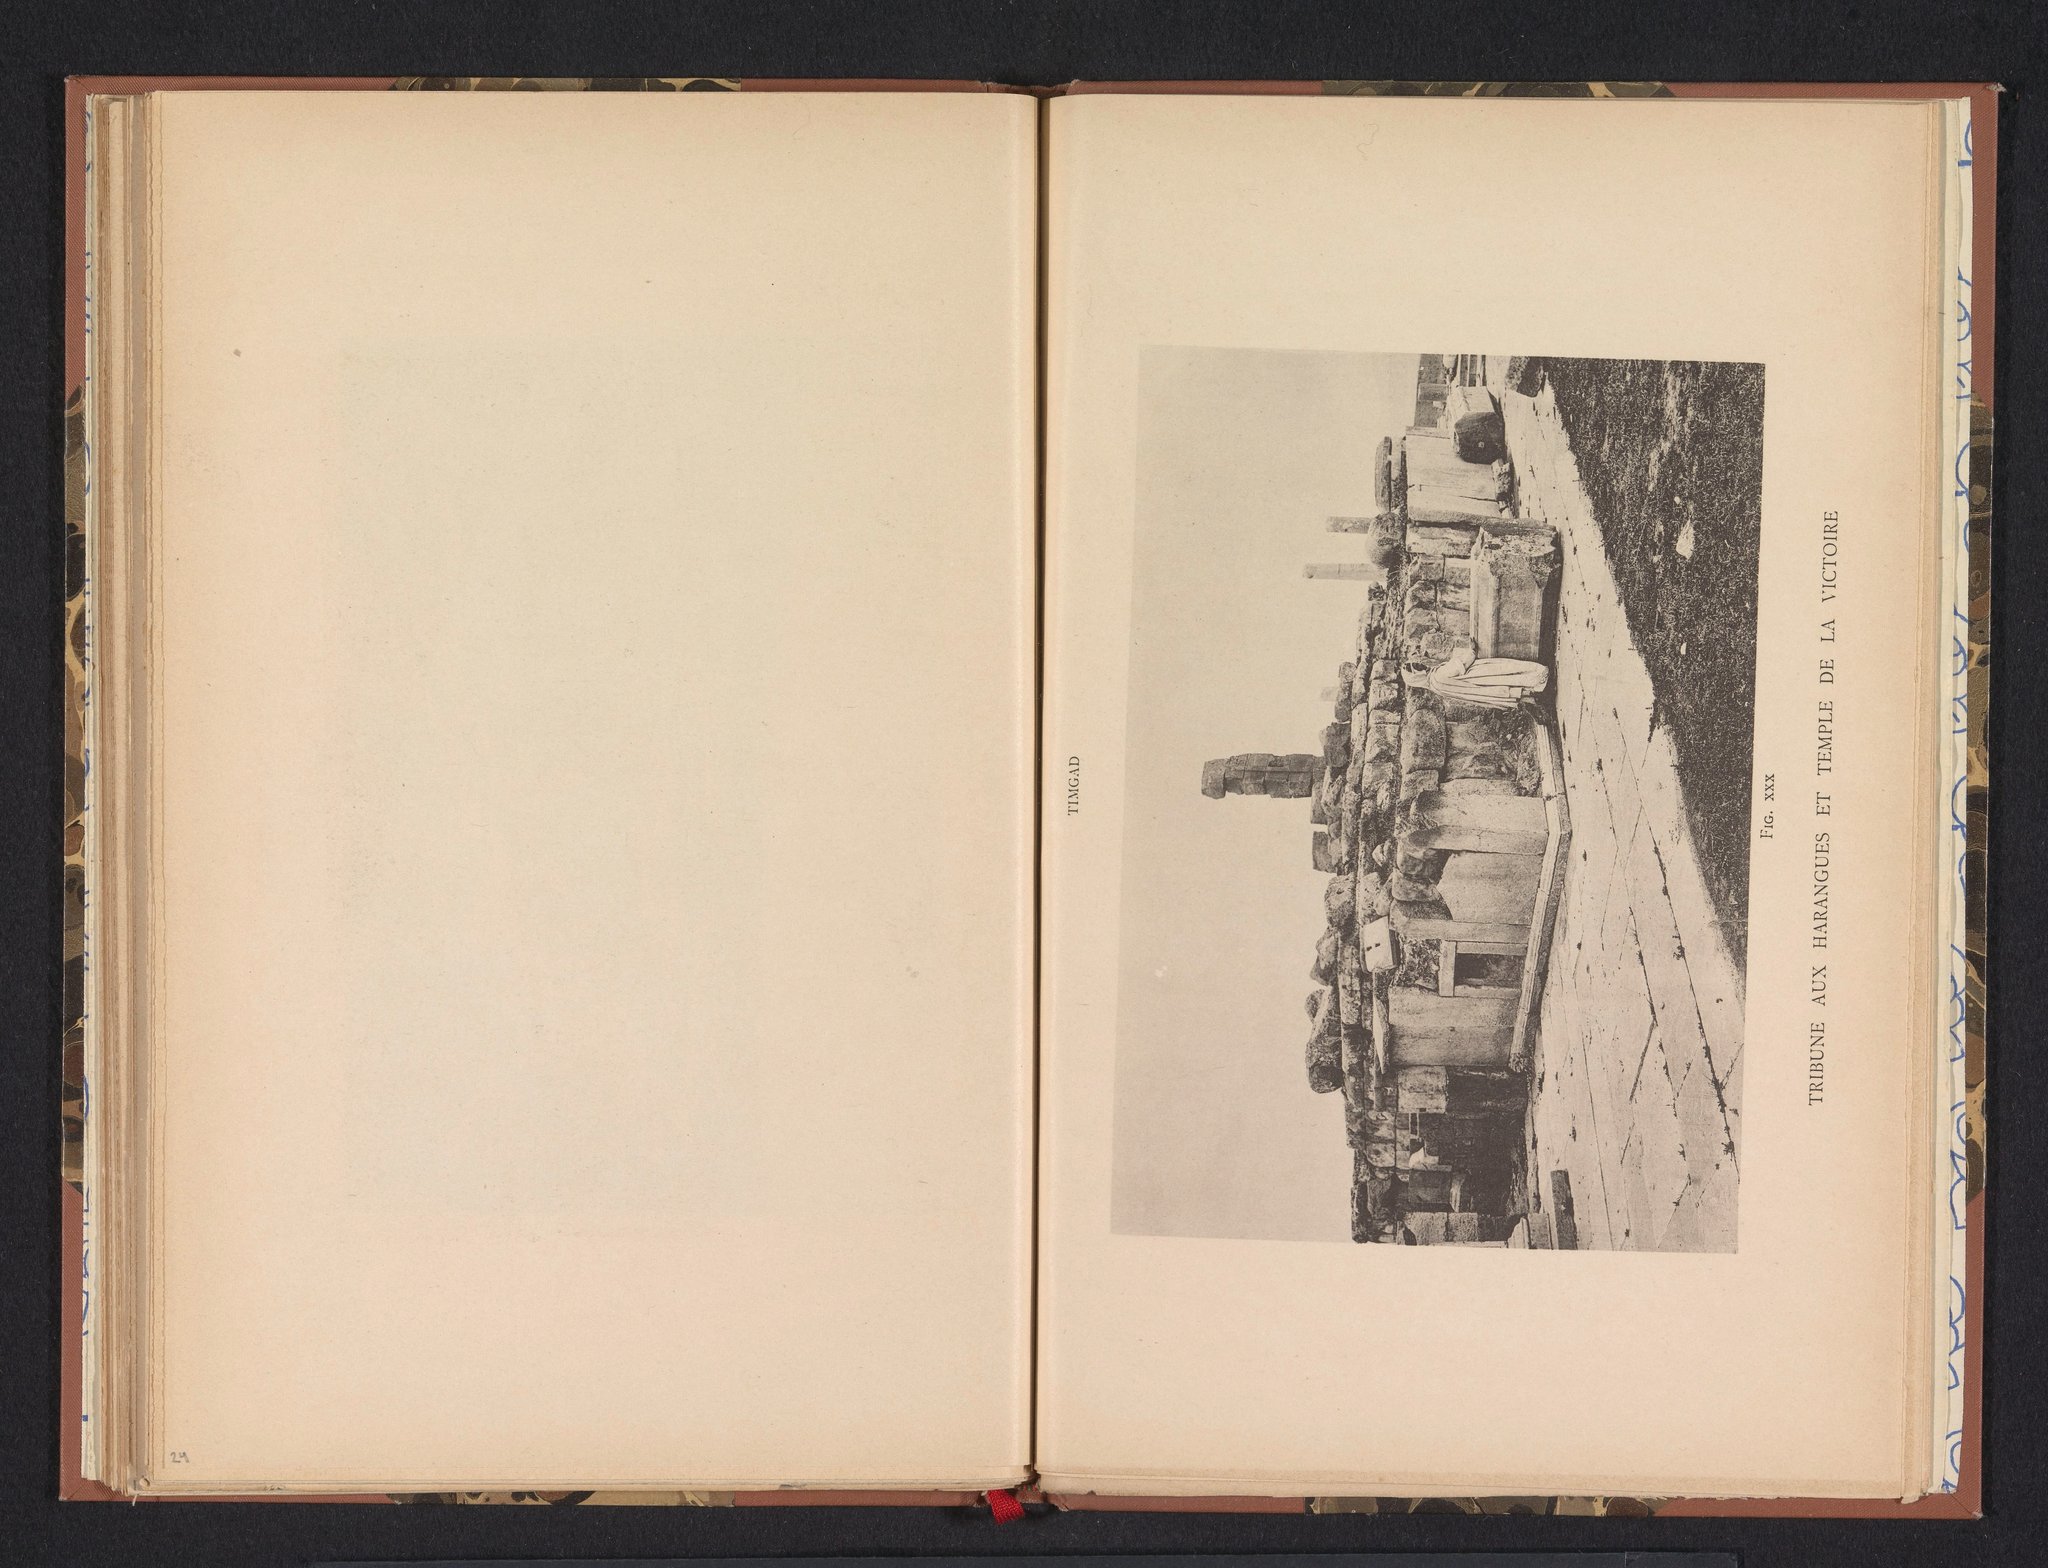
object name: page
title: Tribune aux harangues et Temple de la Victoire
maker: Anonymous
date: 1884-1894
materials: paper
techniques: photograph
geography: timgad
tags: landscape with ruins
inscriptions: number: ‘Fig. XXX’